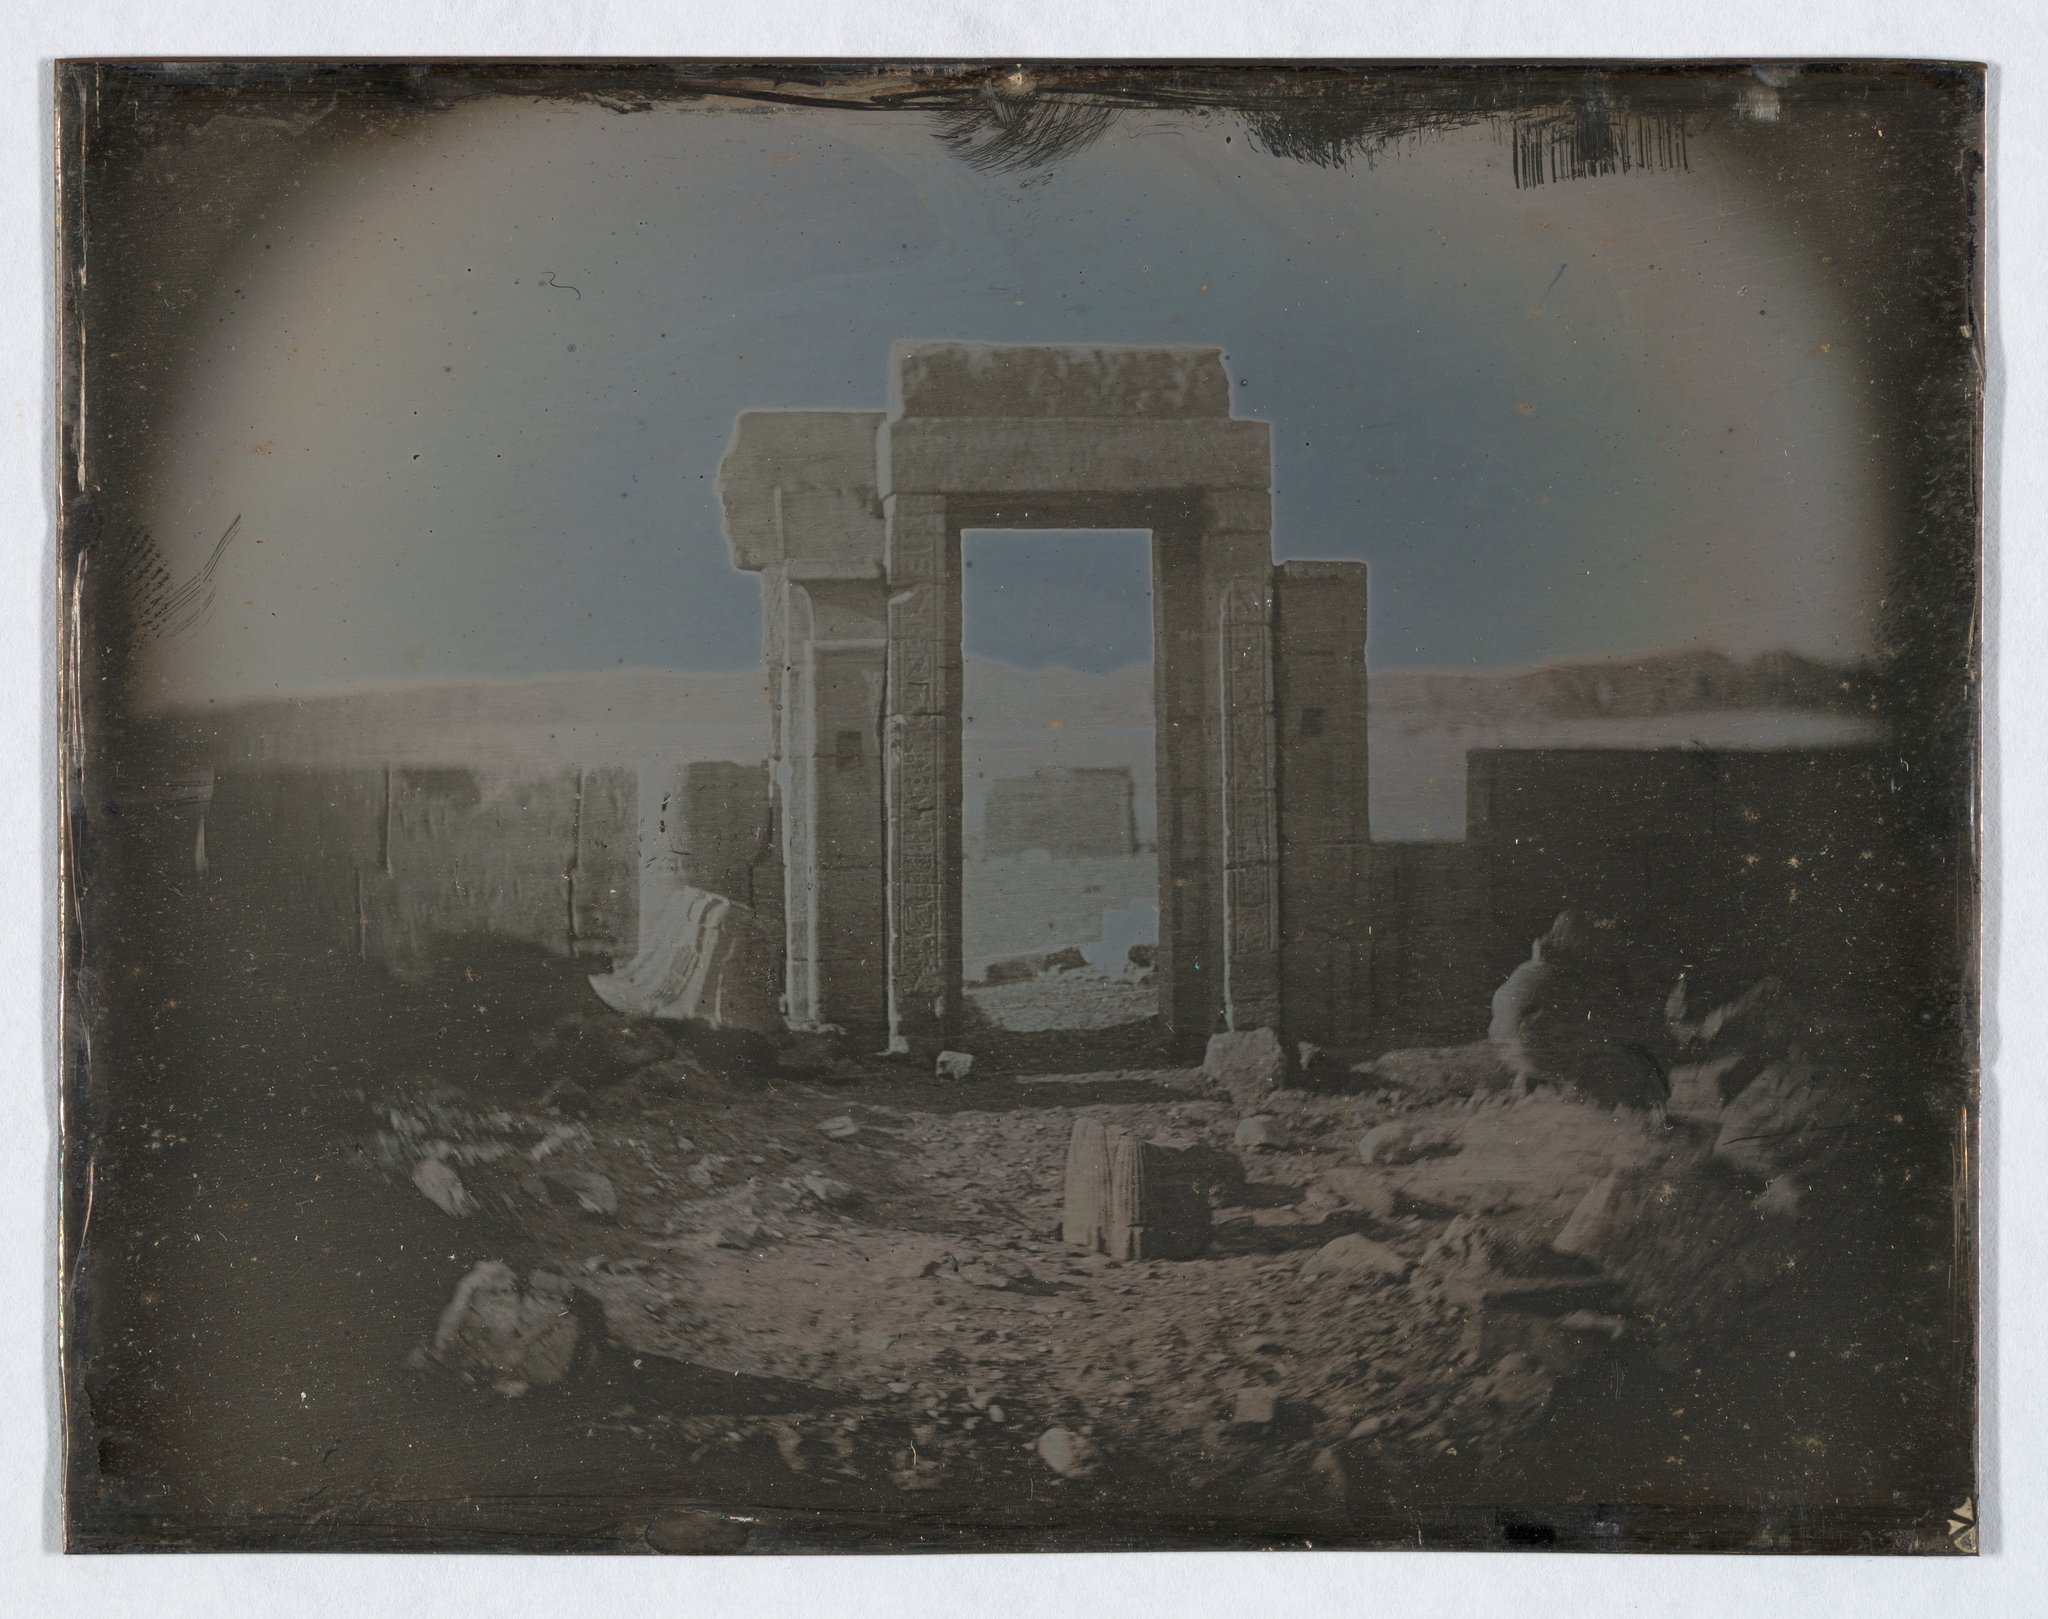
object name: photograph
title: Temple of Horus, Edfu (167. ? Temple.)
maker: joseph-philibert girault de prangey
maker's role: artist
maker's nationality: french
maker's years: 1804-1892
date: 1844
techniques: daguerreotype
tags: architecture,ruins